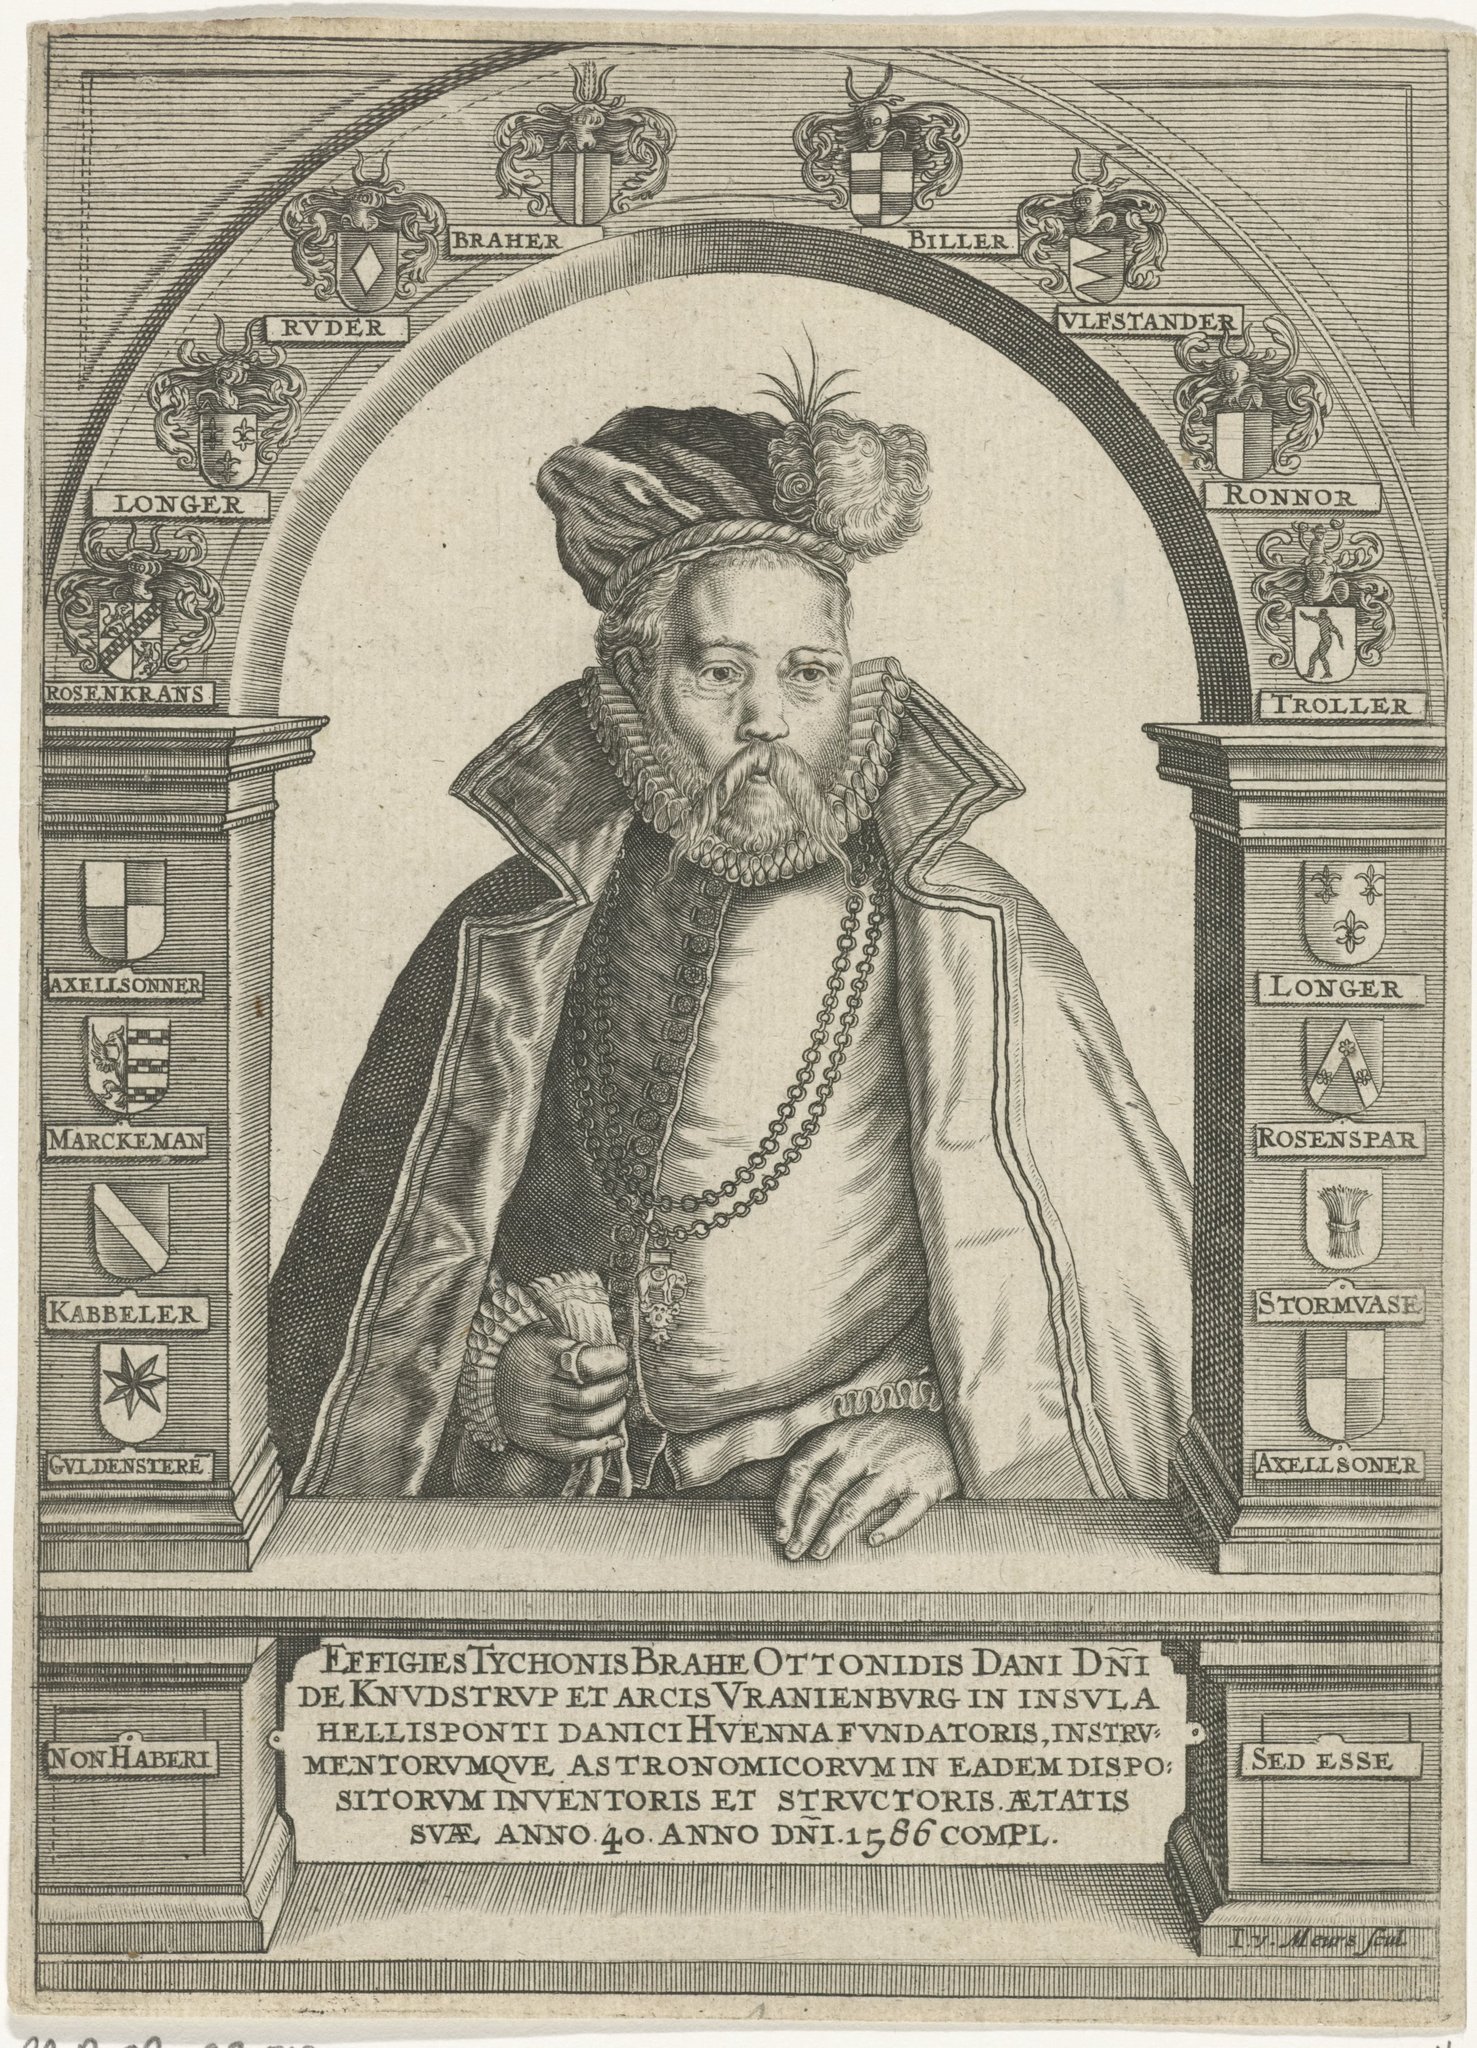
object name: print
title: Portret van Tycho Brahe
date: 1630-1680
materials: paper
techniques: engraving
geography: the hague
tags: prague, tycho brahe, knighthood order of the golden fleece - insignia of a knighthood order, e.g.: badge, chain (with name of order)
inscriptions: collector's mark: Lugt 2228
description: Portret van Tycho Brahe, Deens astronoom. Portret ten halven lijve, in boogvormige nis met familiewapens eromheen. Brahe draagt een muts met pluim op het hoofd en houdt handschoenen in de rechterhand. Om zijn hals een ketting met de orde van het Gulden Vlies.